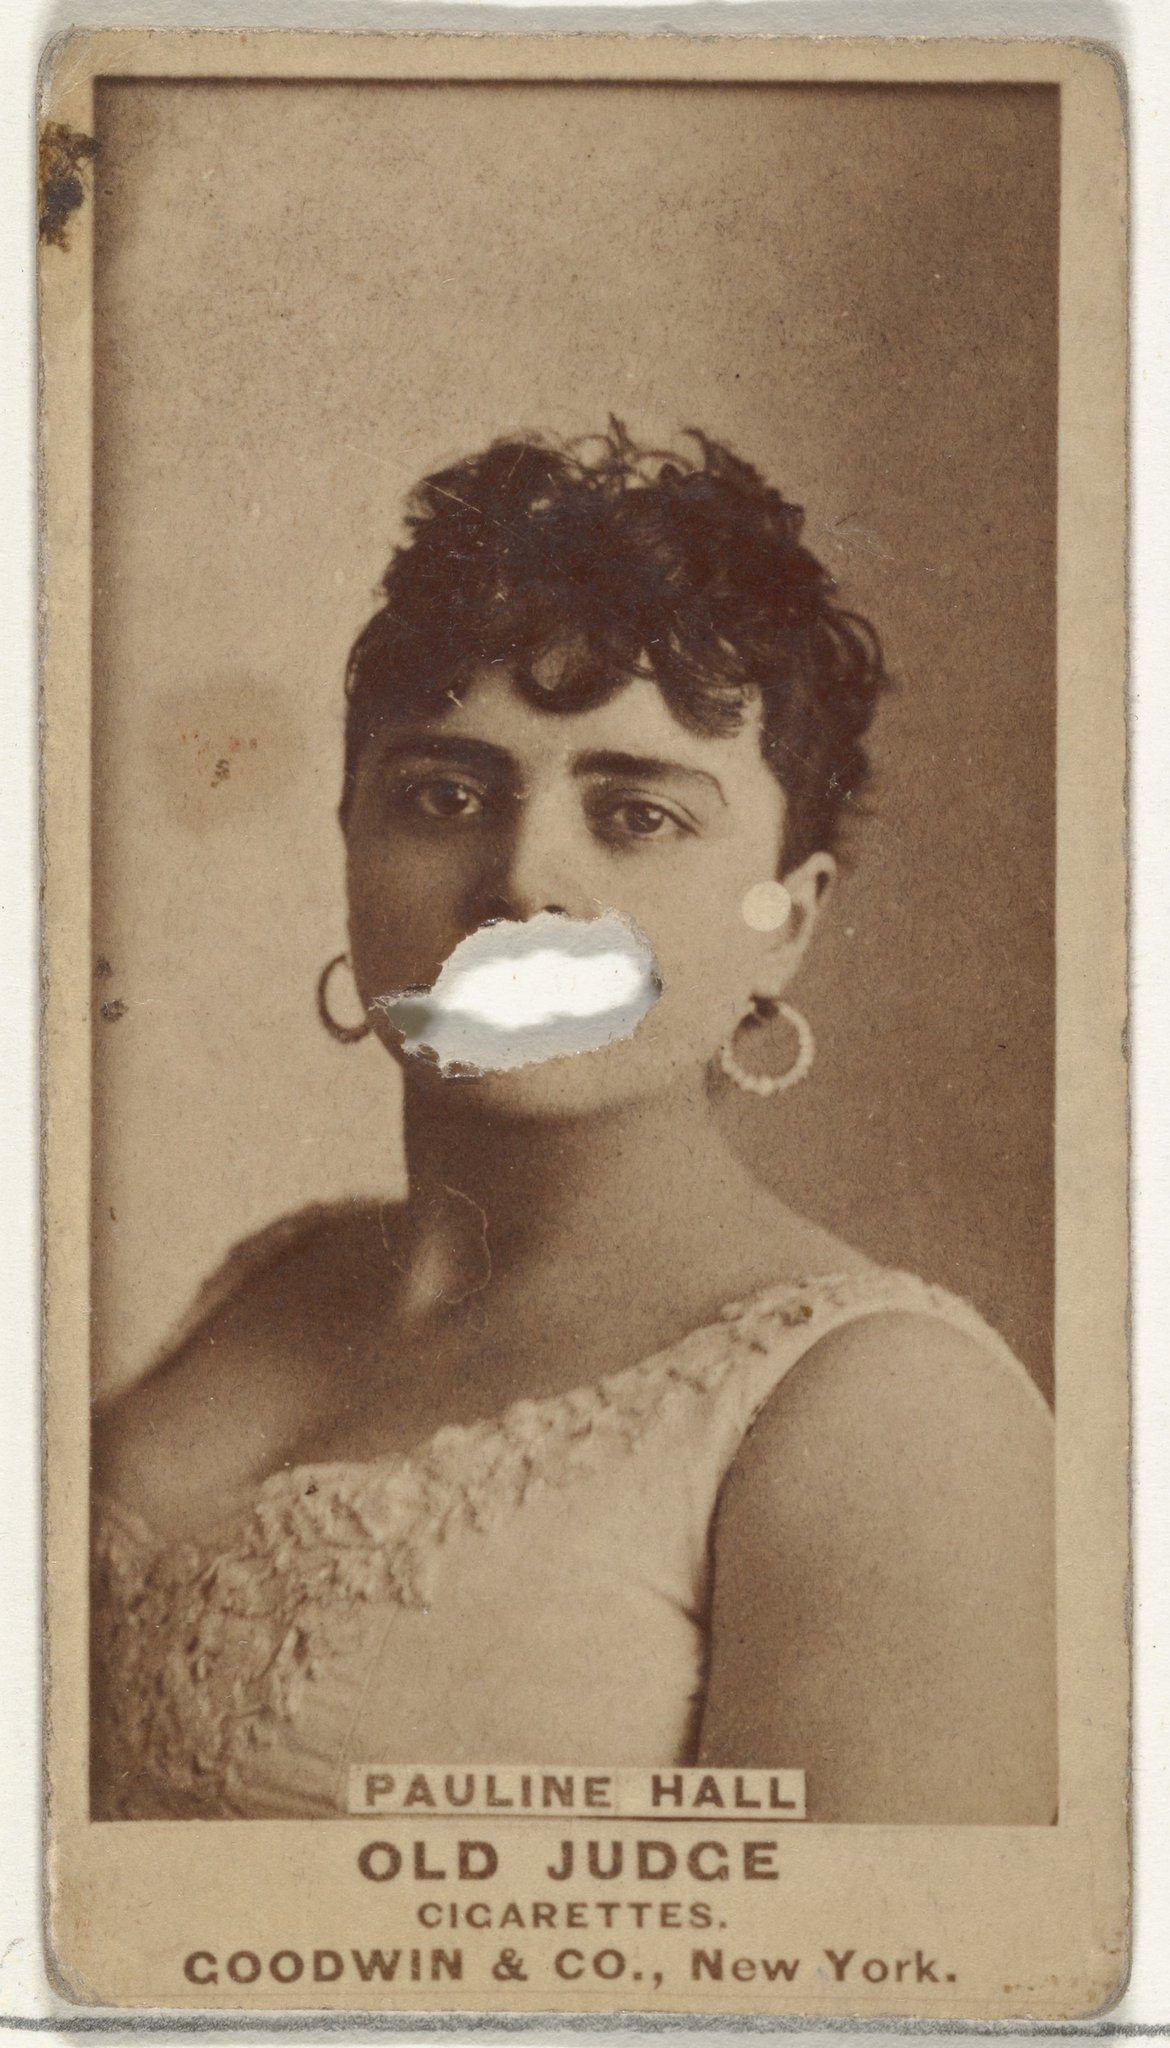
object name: photograph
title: Pauline Hall, from the Actors and Actresses series (N171) for Old Judge Cigarettes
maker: goodwin & company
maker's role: publisher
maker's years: 1850-1950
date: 1886-1890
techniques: albumen silver print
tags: portraits,women,actresses